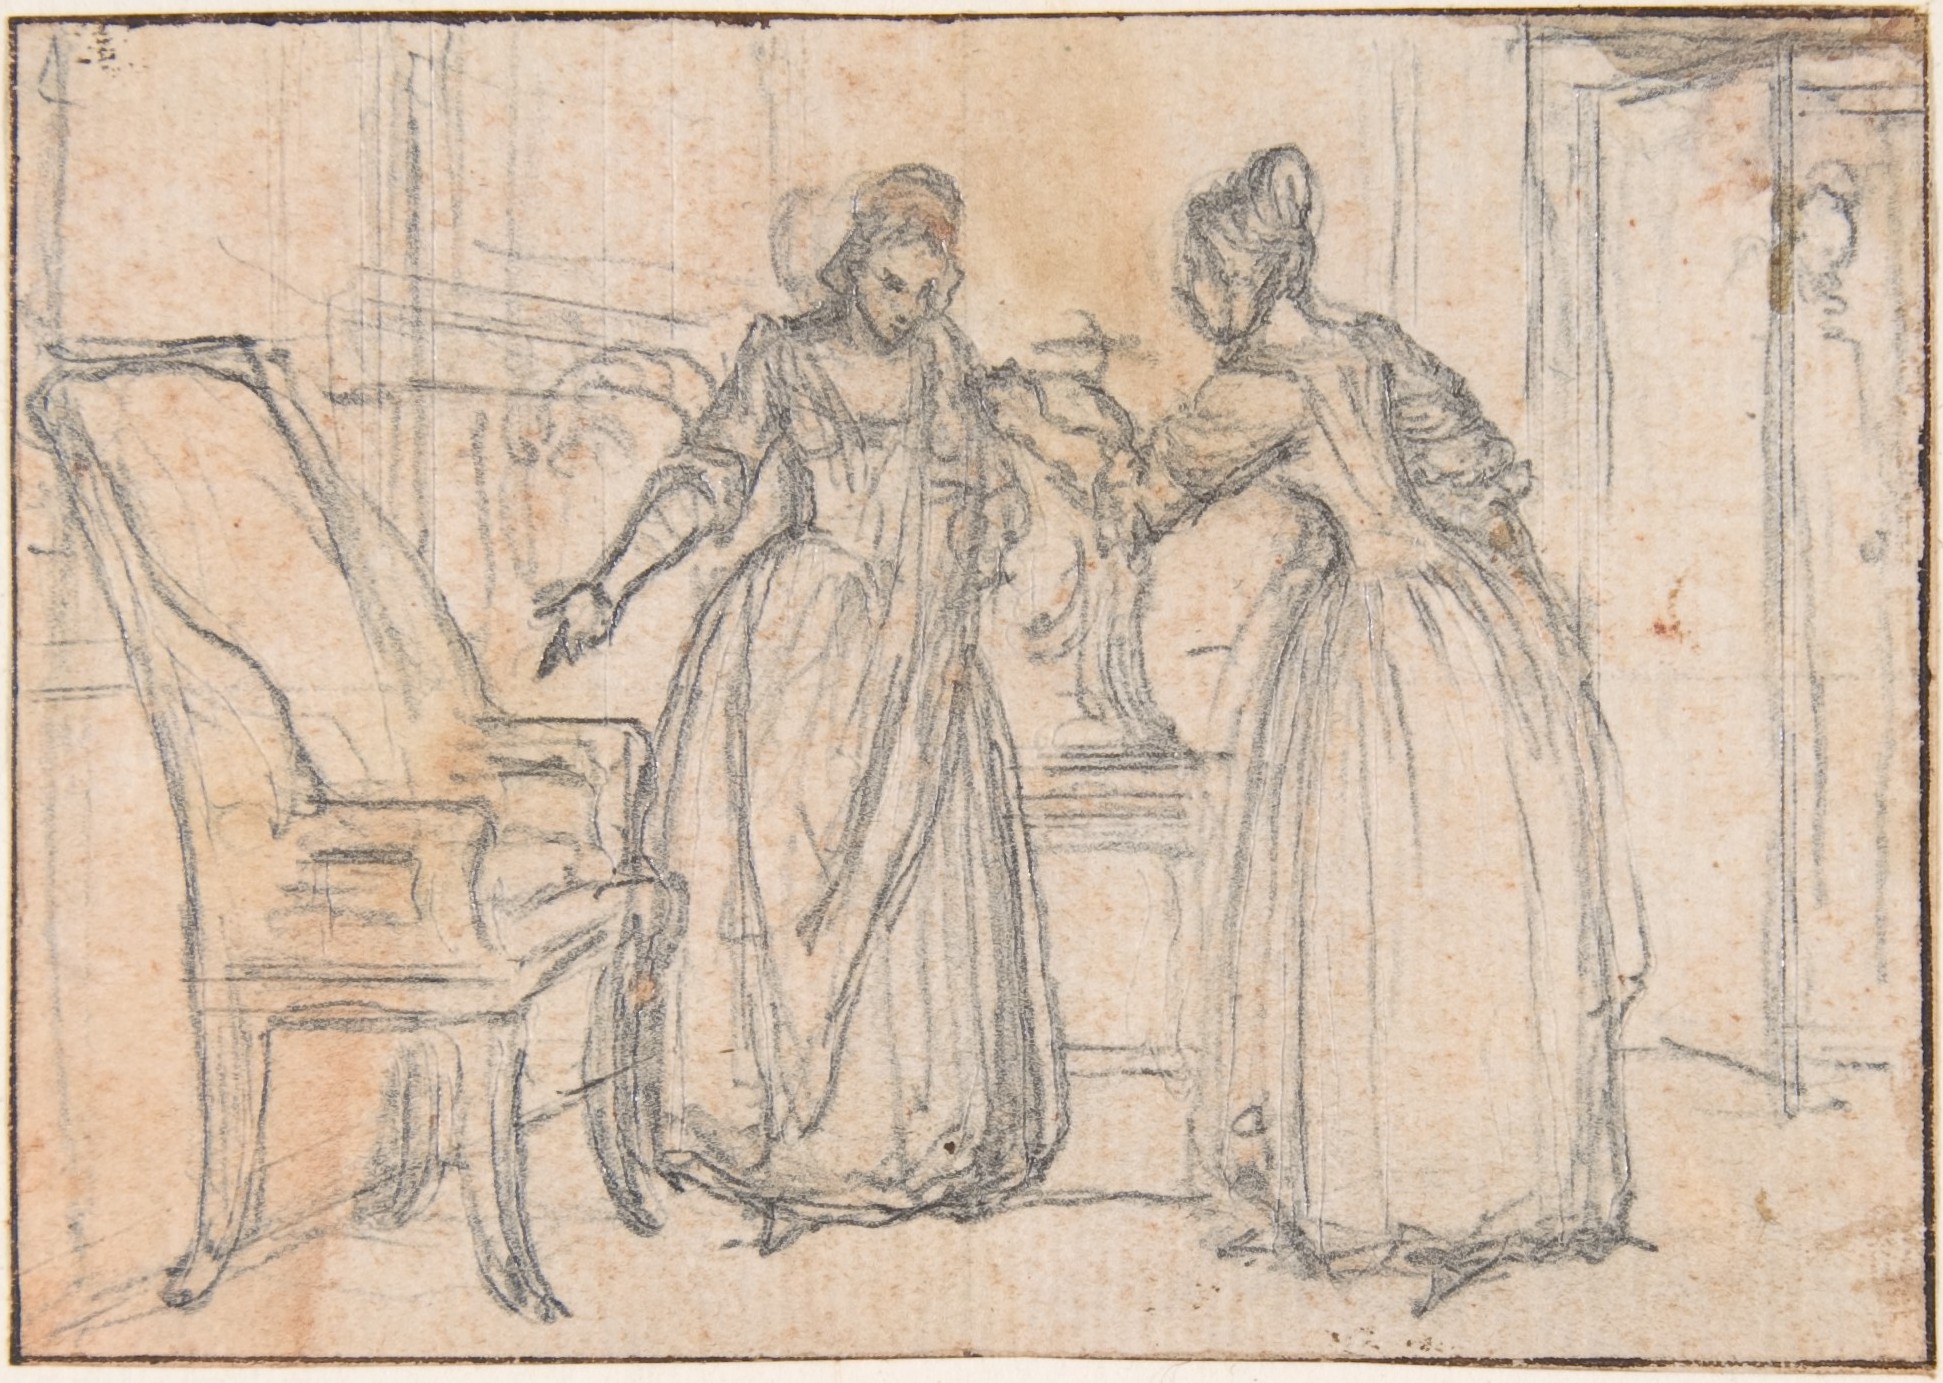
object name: drawing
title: Possible Study for "Songs in the Opera of Flora"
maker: hubert françois gravelot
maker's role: artist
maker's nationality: french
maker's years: 1699-1773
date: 1701-1800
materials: chalk, graphite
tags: women,chairs